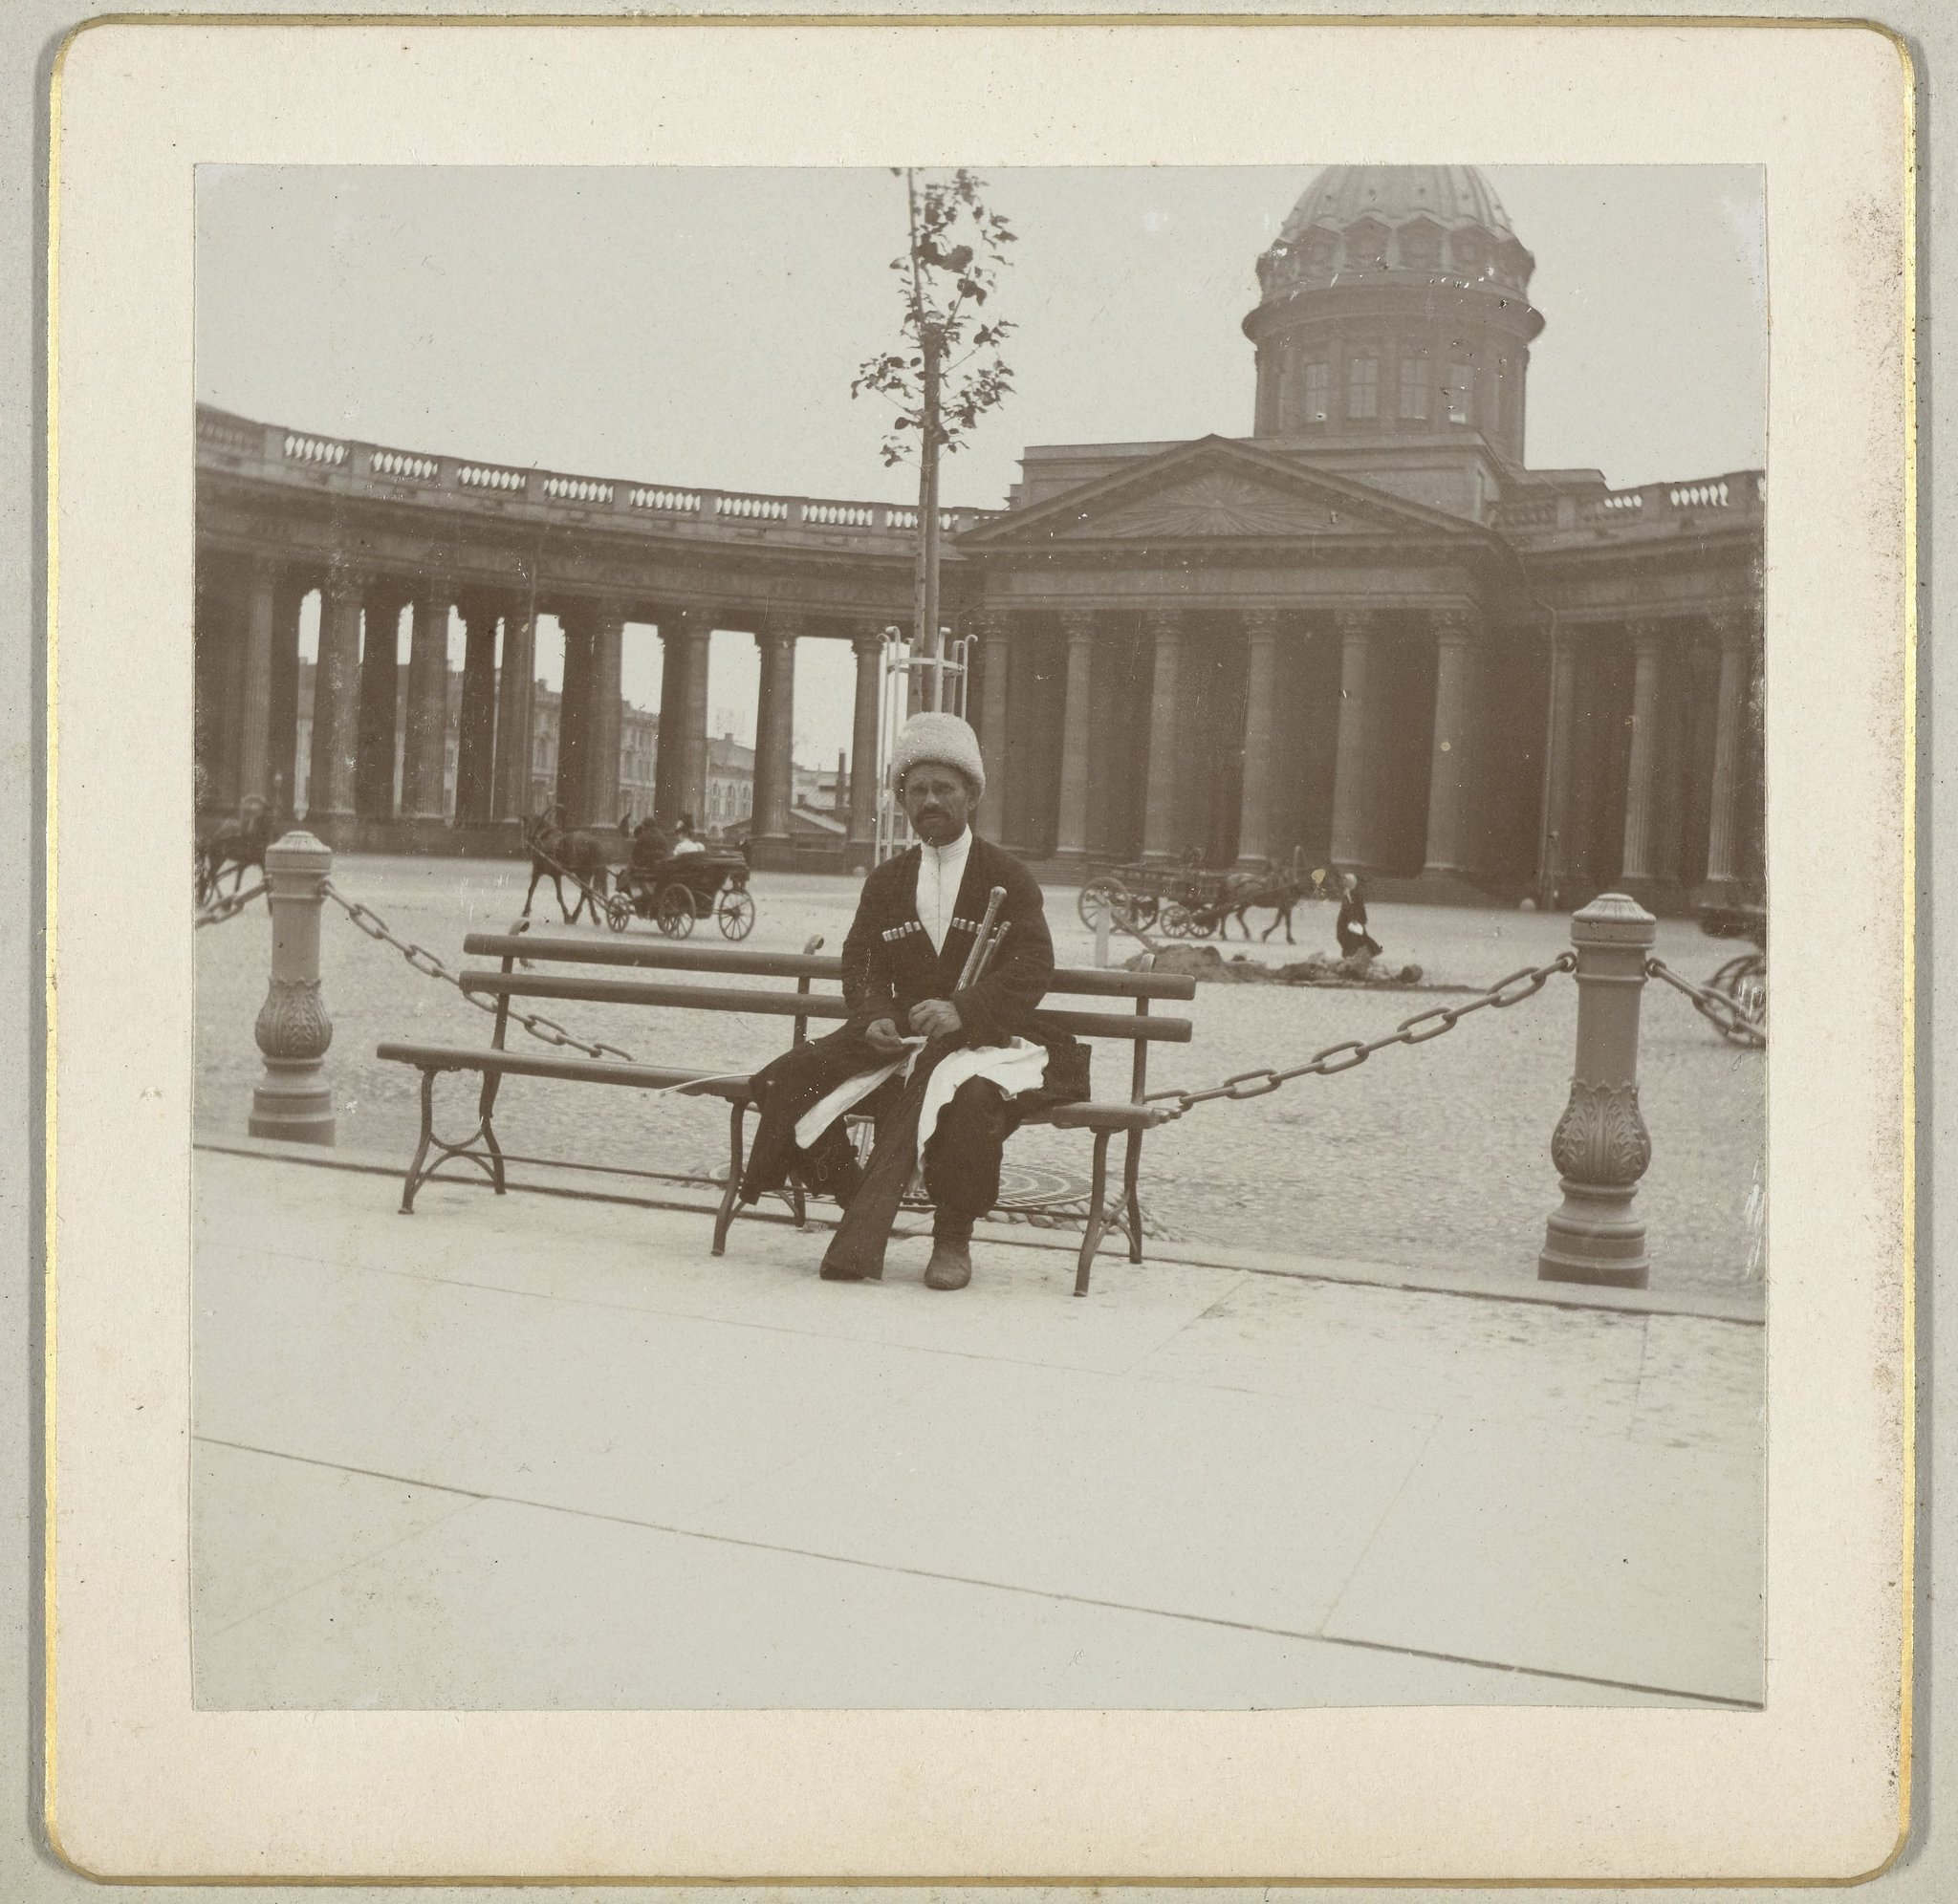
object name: photograph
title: Koopman bij de Kazan kathedraal in Sint-Petersburg.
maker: henry pauw van wieldrecht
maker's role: fotograaf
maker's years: 1863-1912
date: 1898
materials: paper, photographic support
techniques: albumen print